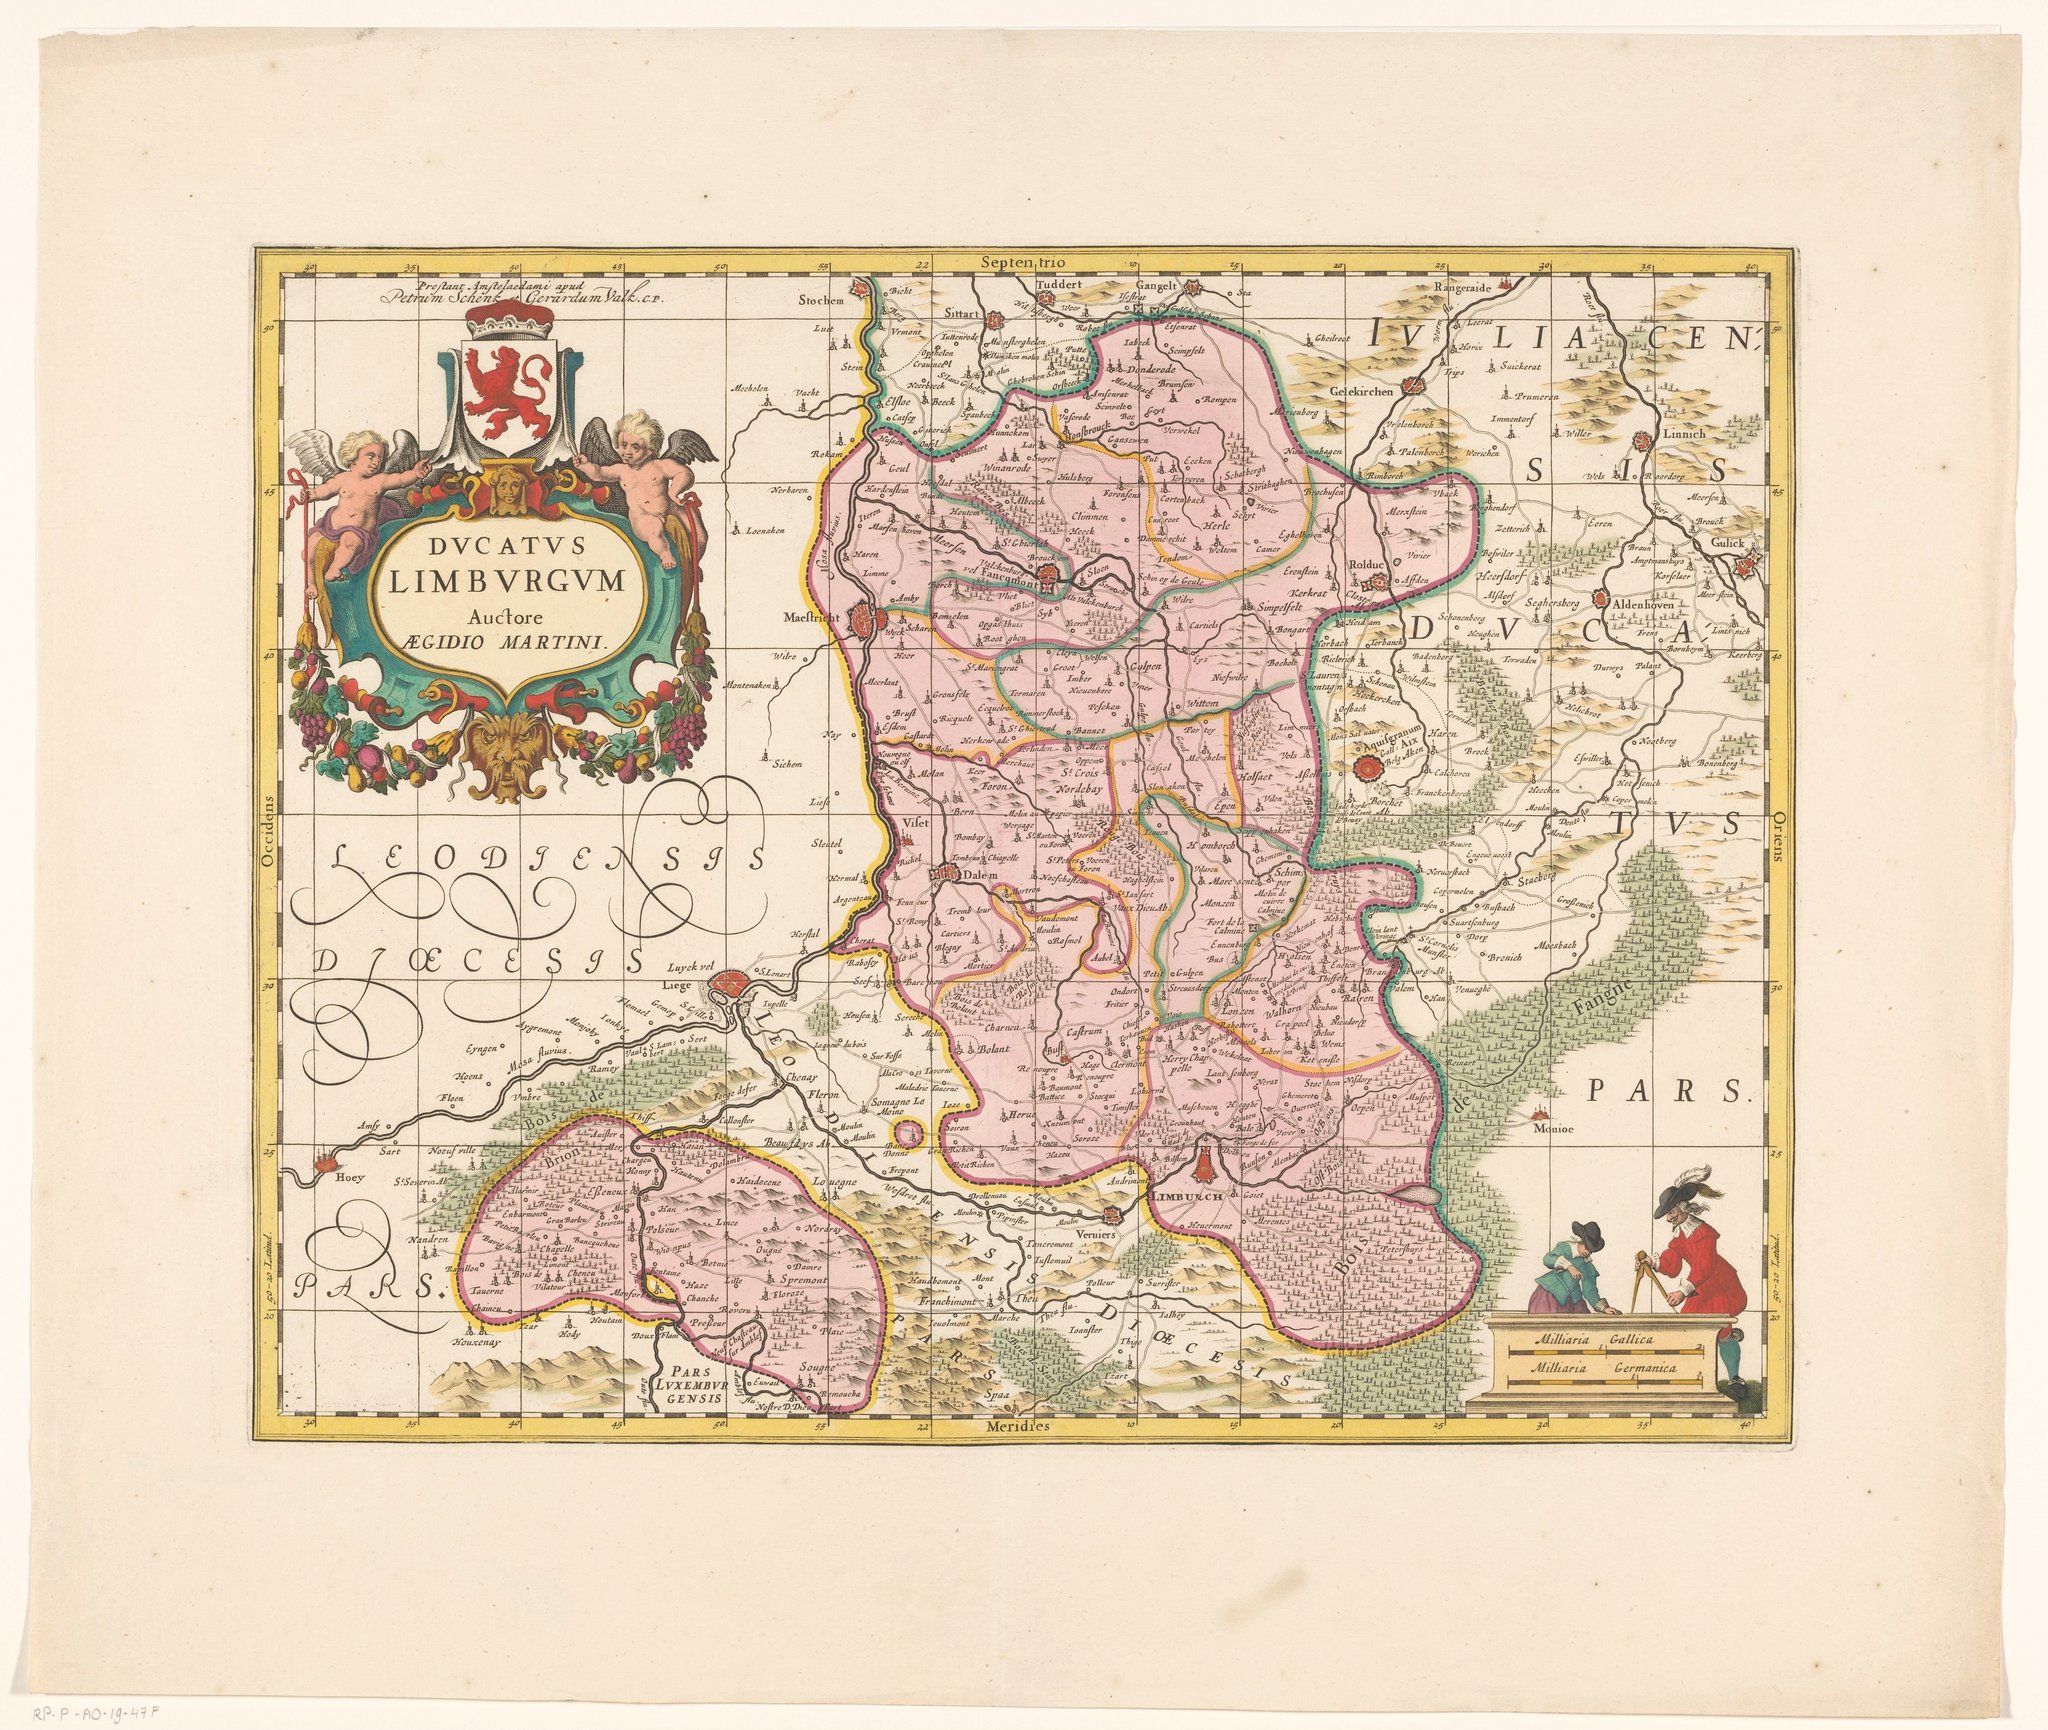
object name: map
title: Ducatus Limburgum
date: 1639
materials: paper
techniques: engraving, hand coloring, letterpress printing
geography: amsterdam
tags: maps of separate countries or regions, coat of arms (as symbol of the state, etc.) (+ province; provincial)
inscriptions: collector's mark: Lugt 2228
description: Kaart van het hertogdom Limburg. Linksboven de titelcartouche met bovenin het wapen van het hertogdom Limburg. Rechtsonder een cartouche met twee schaalstokken: 2 Milliaria Gallica / 1 1/2 Milliaria Germanica. De kaart is voorzien van een coördinaten-net en gradenverdeling langs de randen.